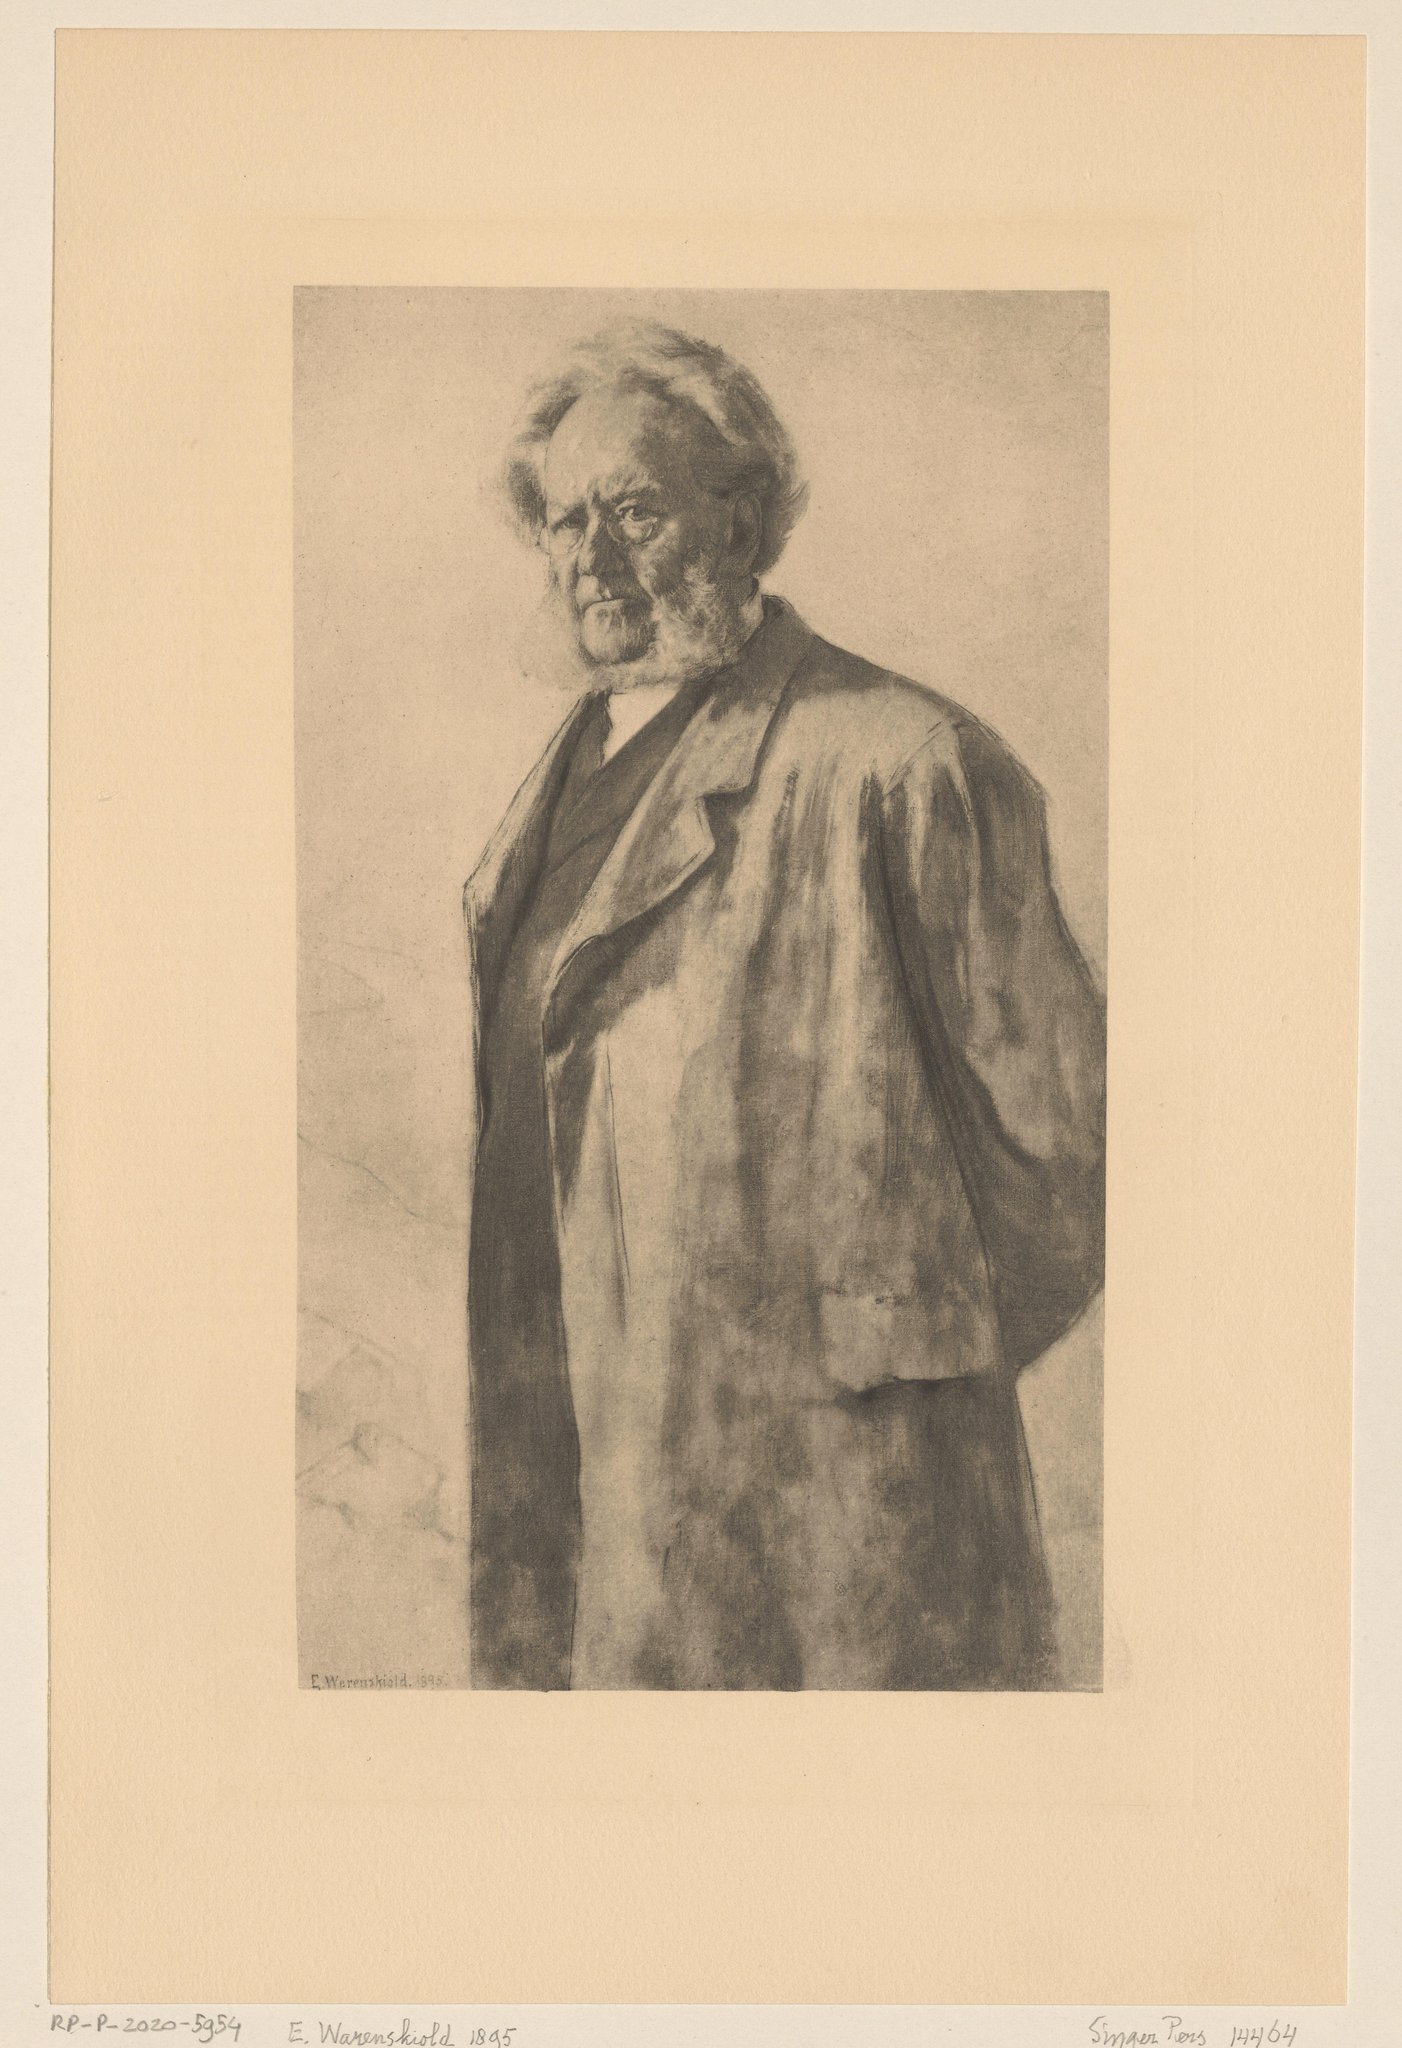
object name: photomechanical print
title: Portret van Henrik Ibsen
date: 1895-1915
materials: paper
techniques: photoaquatint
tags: historical persons, portrait of a writer